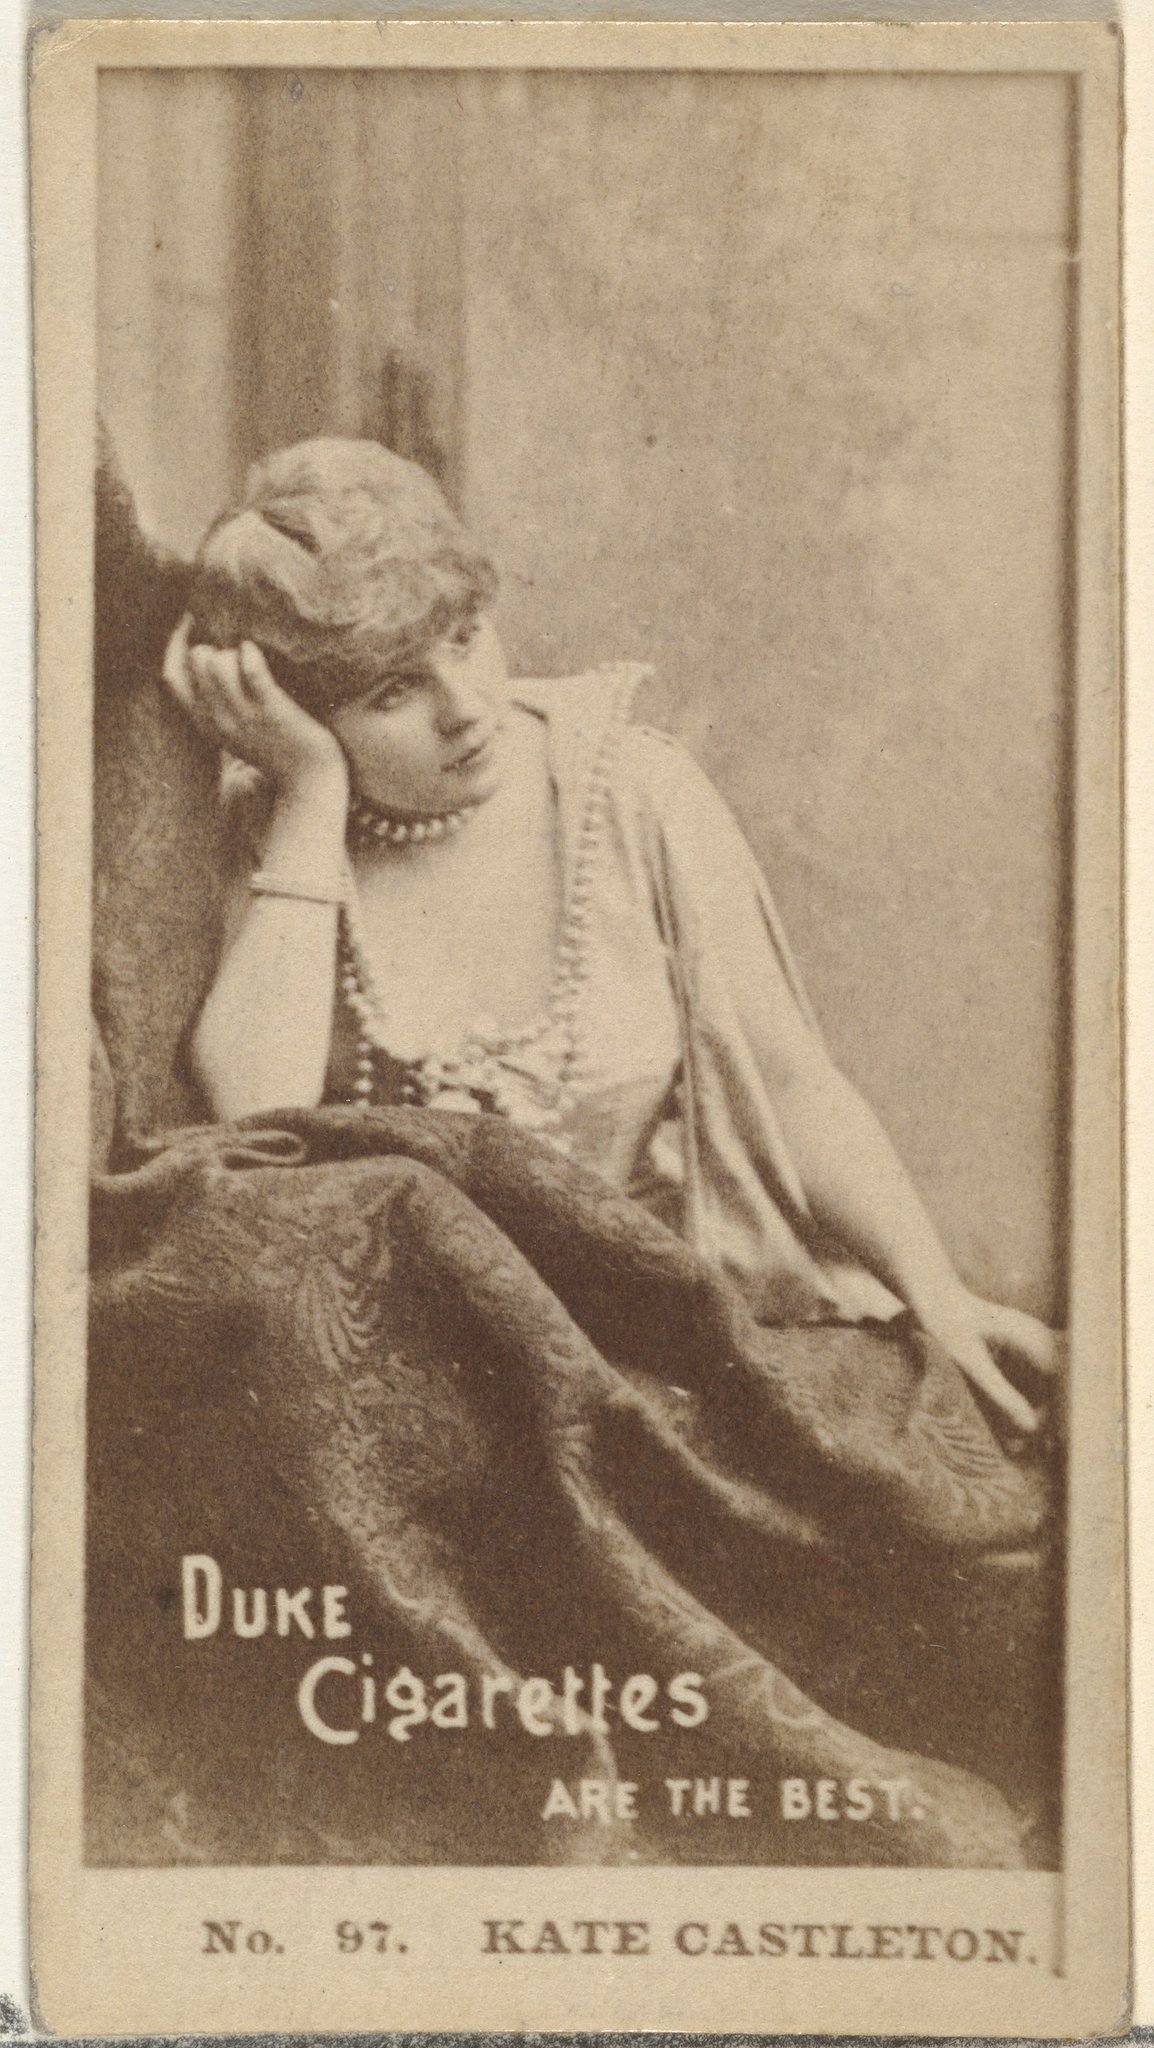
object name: photograph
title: Card Number 97, Kate Castleton, from the Actors and Actresses series (N145-6) issued by Duke Sons & Co. to promote Duke Cigarettes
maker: w. duke, sons & co.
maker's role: publisher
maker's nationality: american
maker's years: 1870-1920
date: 1880-1889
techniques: albumen silver print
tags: portraits,women,actresses